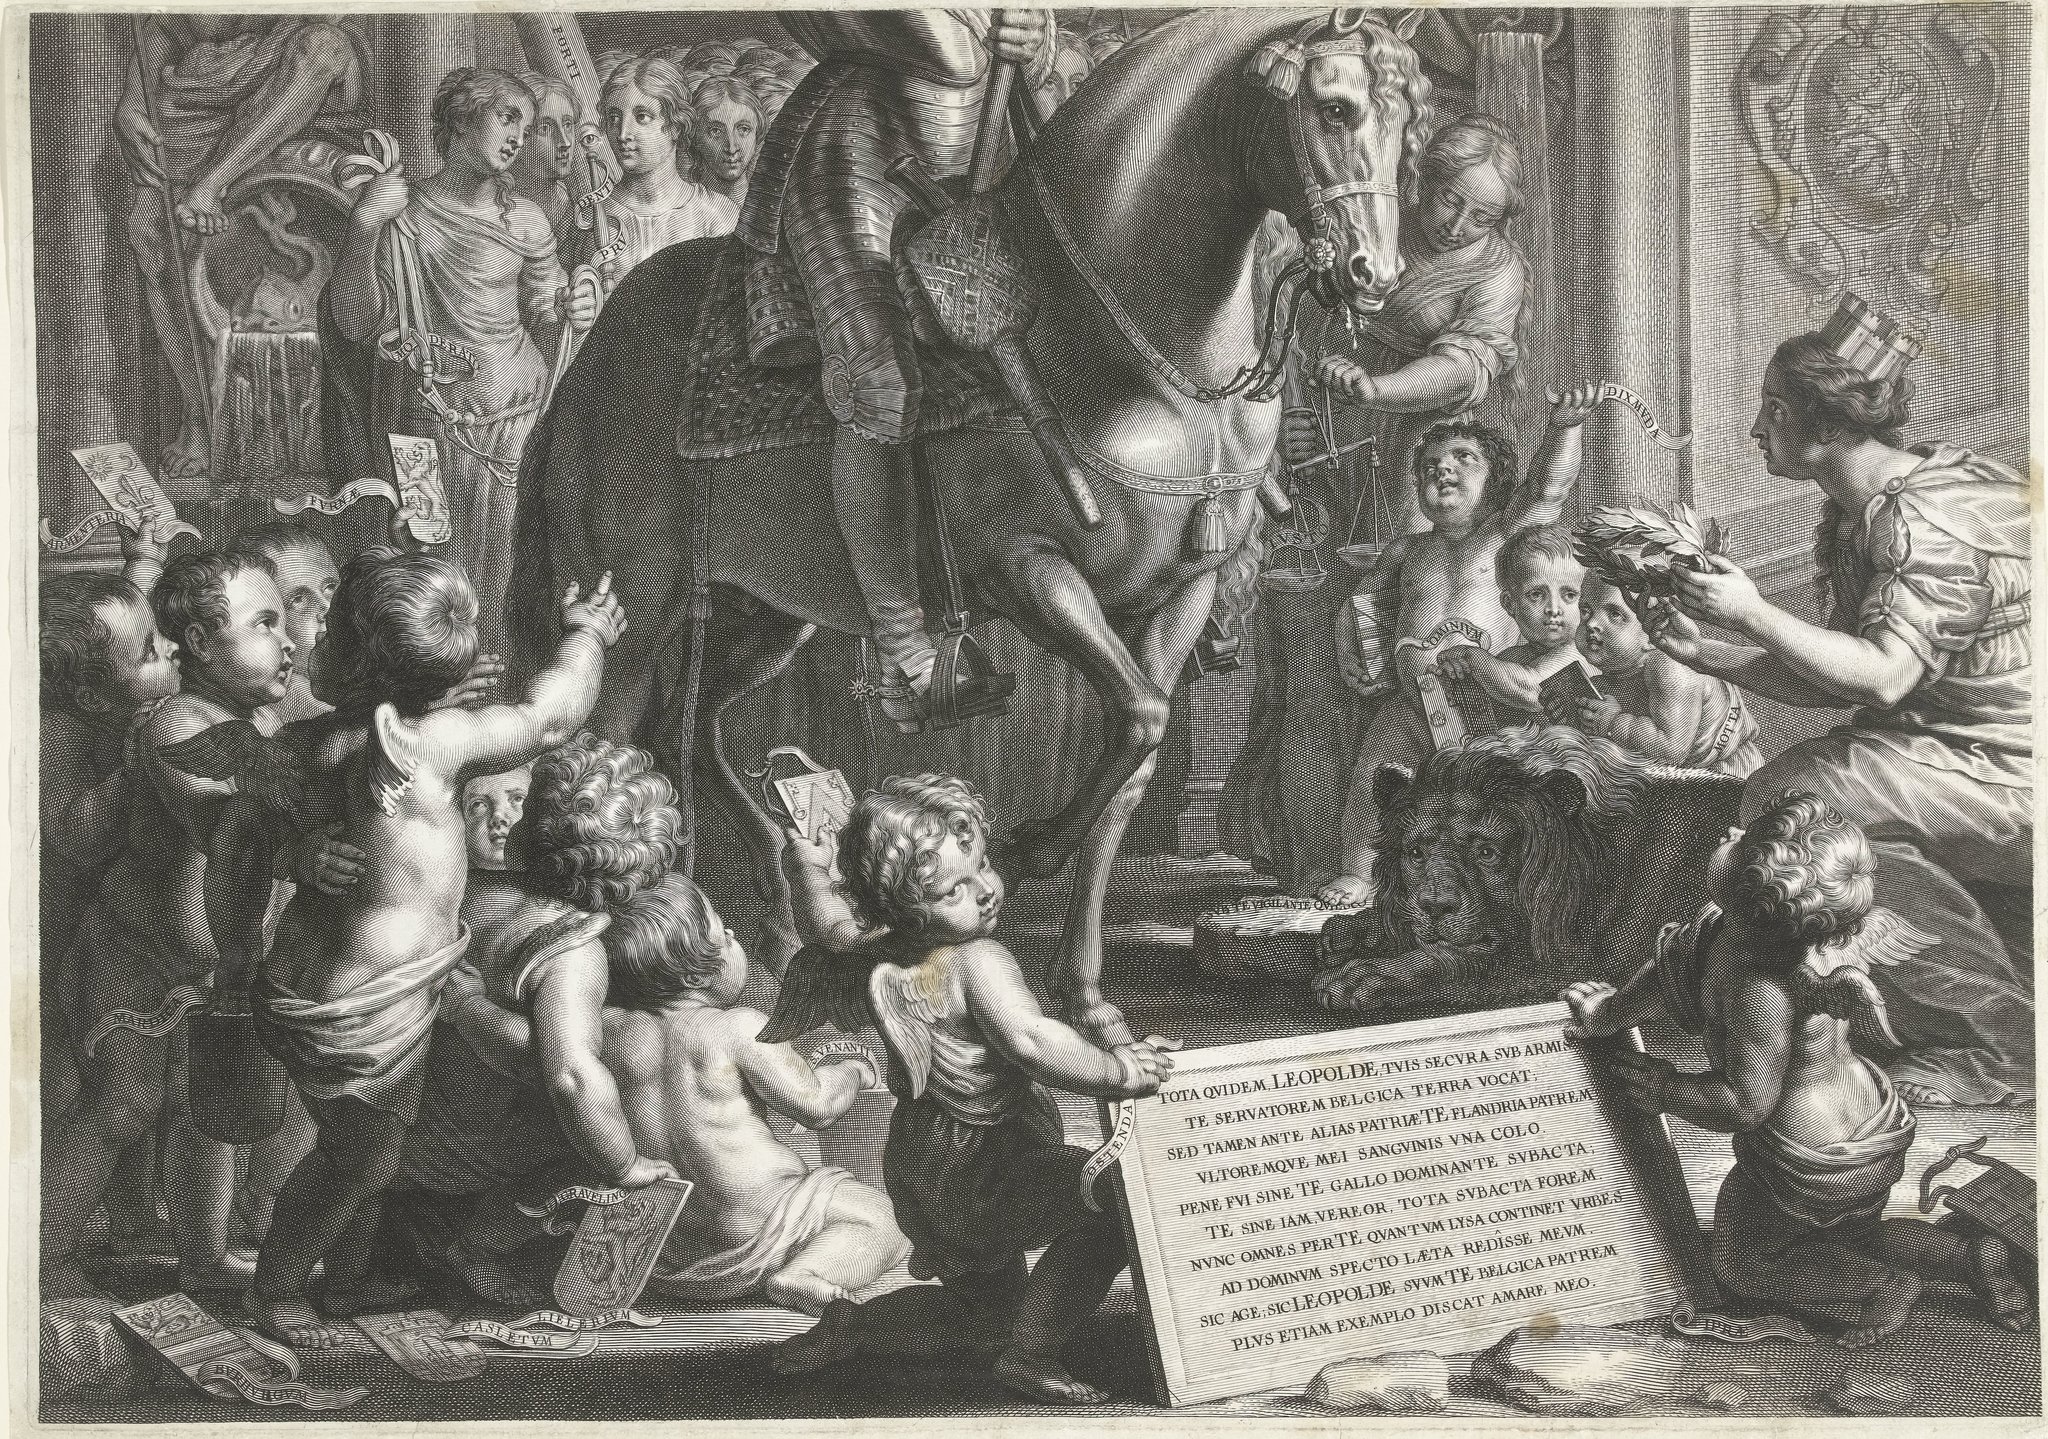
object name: print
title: Intocht van Leopold Willem, landvoogd der Zuidelijke Nederlanden, te Gent (linksonder)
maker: schelte adamsz. bolswert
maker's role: print maker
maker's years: 1586-1659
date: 1653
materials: paper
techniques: engraving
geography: antwerp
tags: vienna, leopold willem van oostenrijk (landvoogd der zuidelijke nederlanden), equestrian state-portrait, personification of a city, town-patron(ess), conqueror triumphing, triumphal entry of victor, the four cardinal virtues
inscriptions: collector's mark: Lugt 240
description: Intocht van Leopold Willem, landvoogd der Zuidelijke Nederlanden, te Gent. Prent bestaande uit vier delen. Dit is het deel linksonder. Putti met de wapenschilden van verschillende Vlaamse steden en gewesten ontvangen Leopold Willem enthousiast. De Gentse stedenmaagd knielt voor hem en houdt een lauwerkrans in haar hand om hem te lauweren. Achter het paard de kardinale deugden, Rechtvaardigheid, Matigheid, Kracht en Voorzichtigheid.